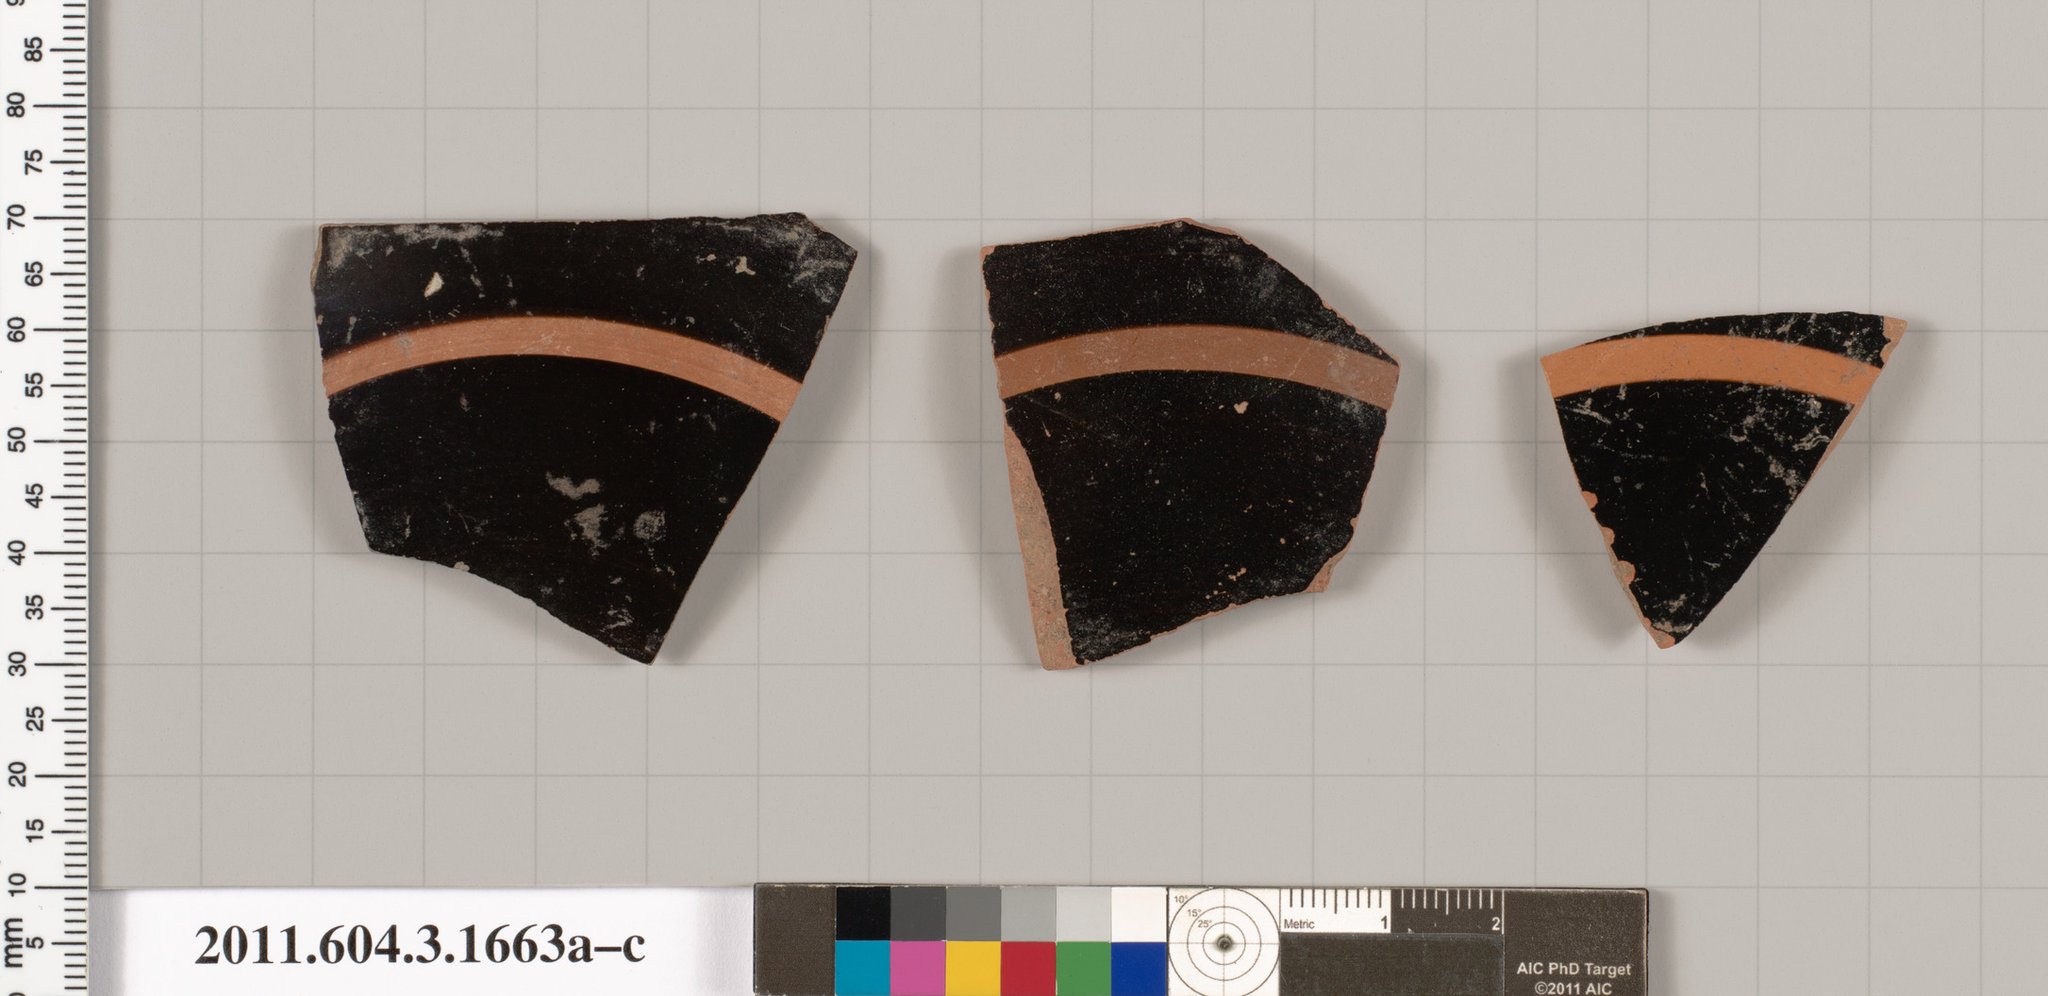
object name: kylix fragment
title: Terracotta fragments of kylikes: Band or lip cups (drinking cups)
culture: greek, attic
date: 550-526 BCE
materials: terracotta